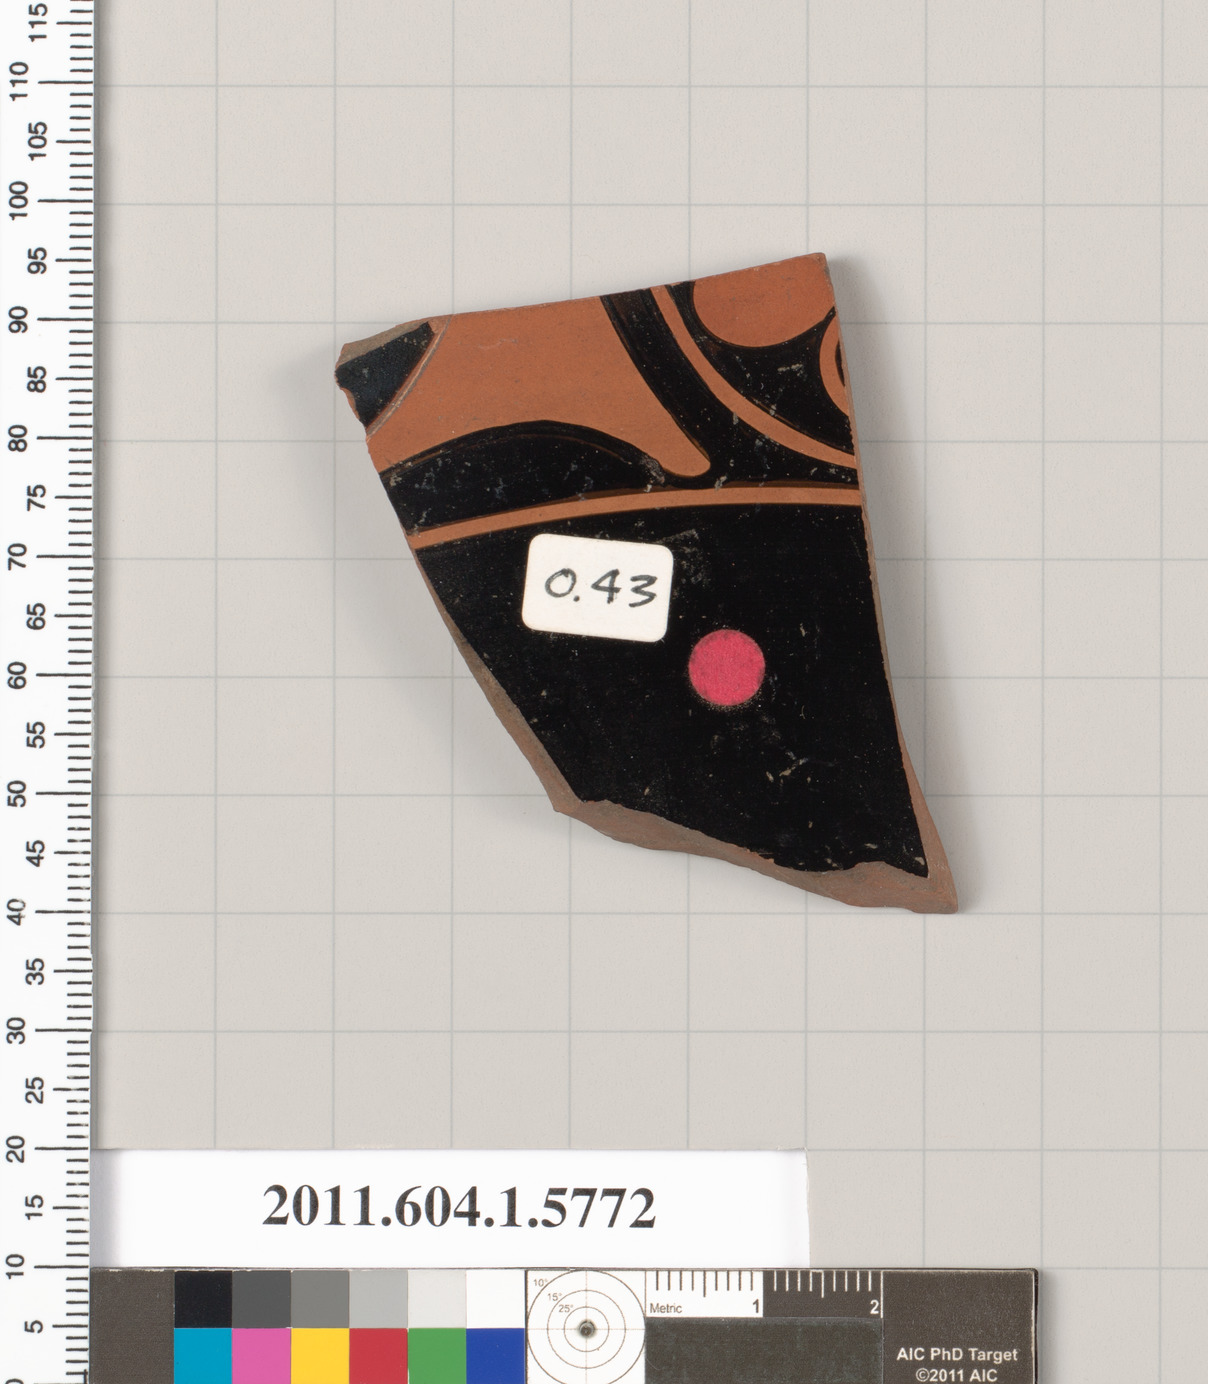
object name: kylix fragment, eye cup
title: Terracotta fragment of a kylix: eye-cup (drinking cup)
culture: greek, attic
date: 525-510 BCE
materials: terracotta